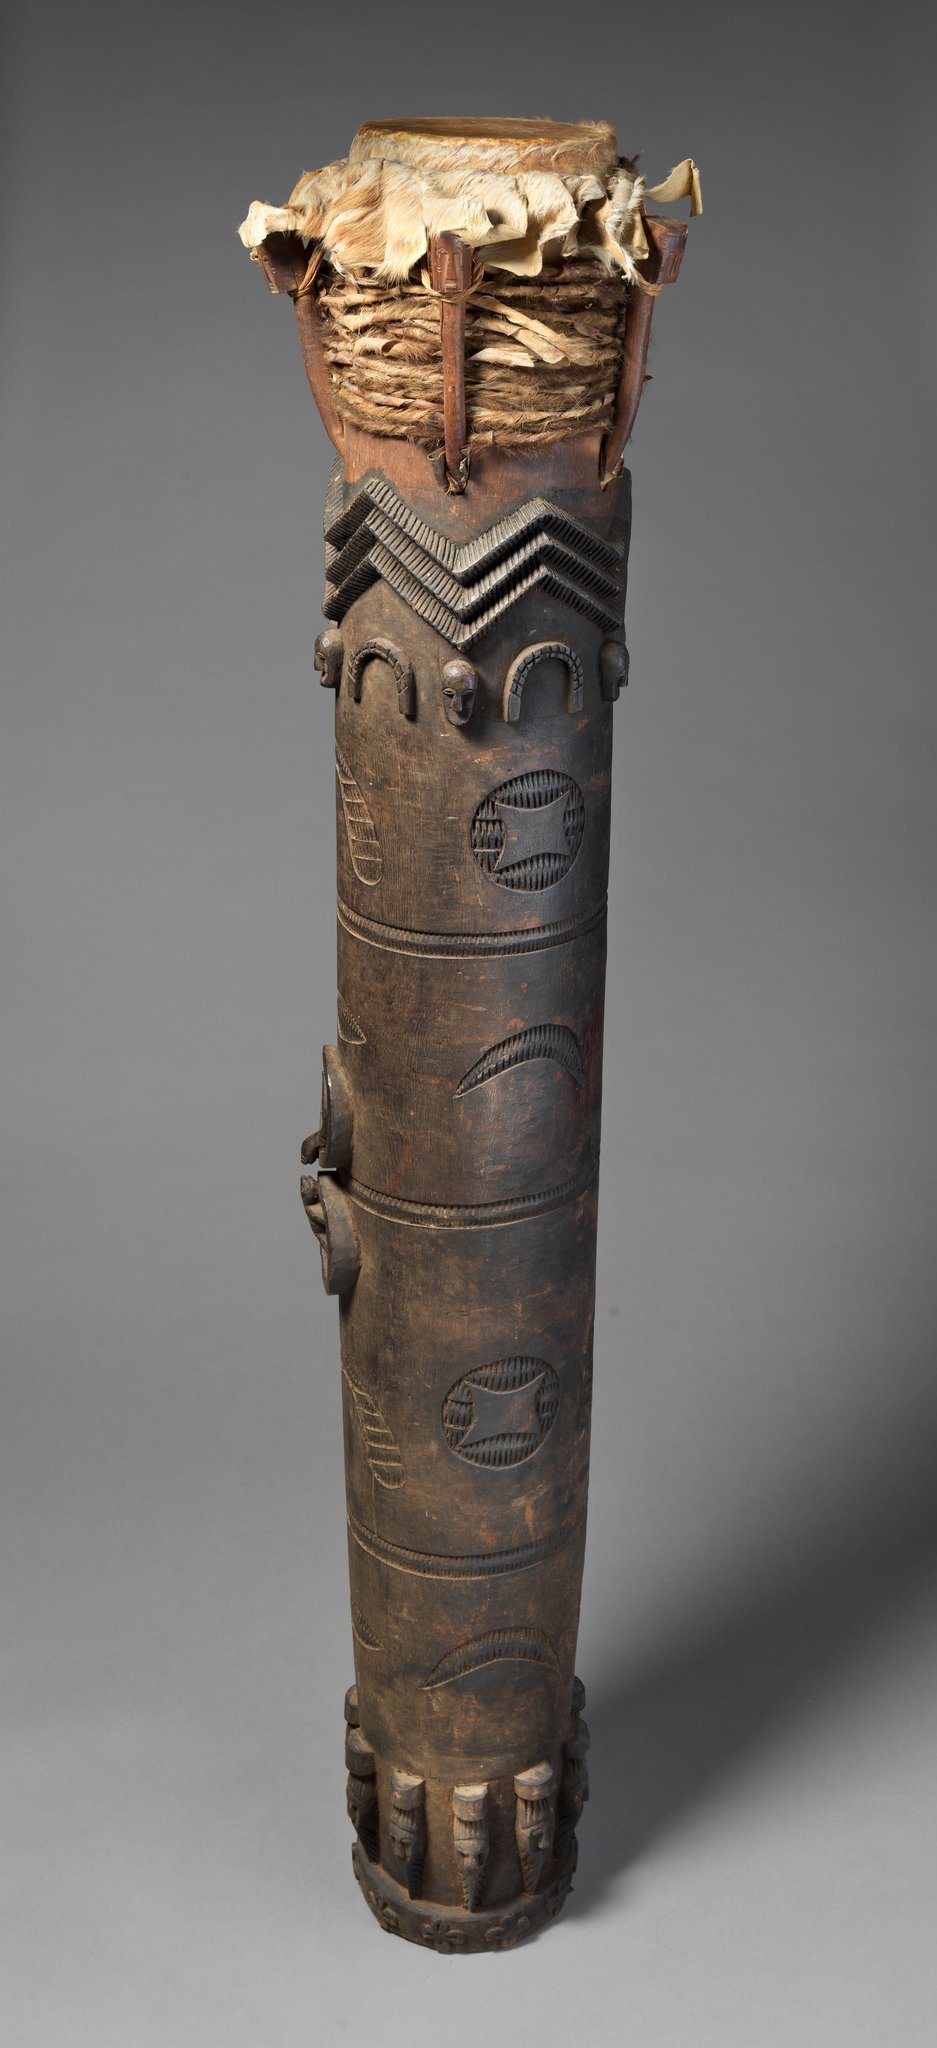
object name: fokwé long drum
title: Fokwé (long drum)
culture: attie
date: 1801-1900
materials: fur, wood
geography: ivory coast